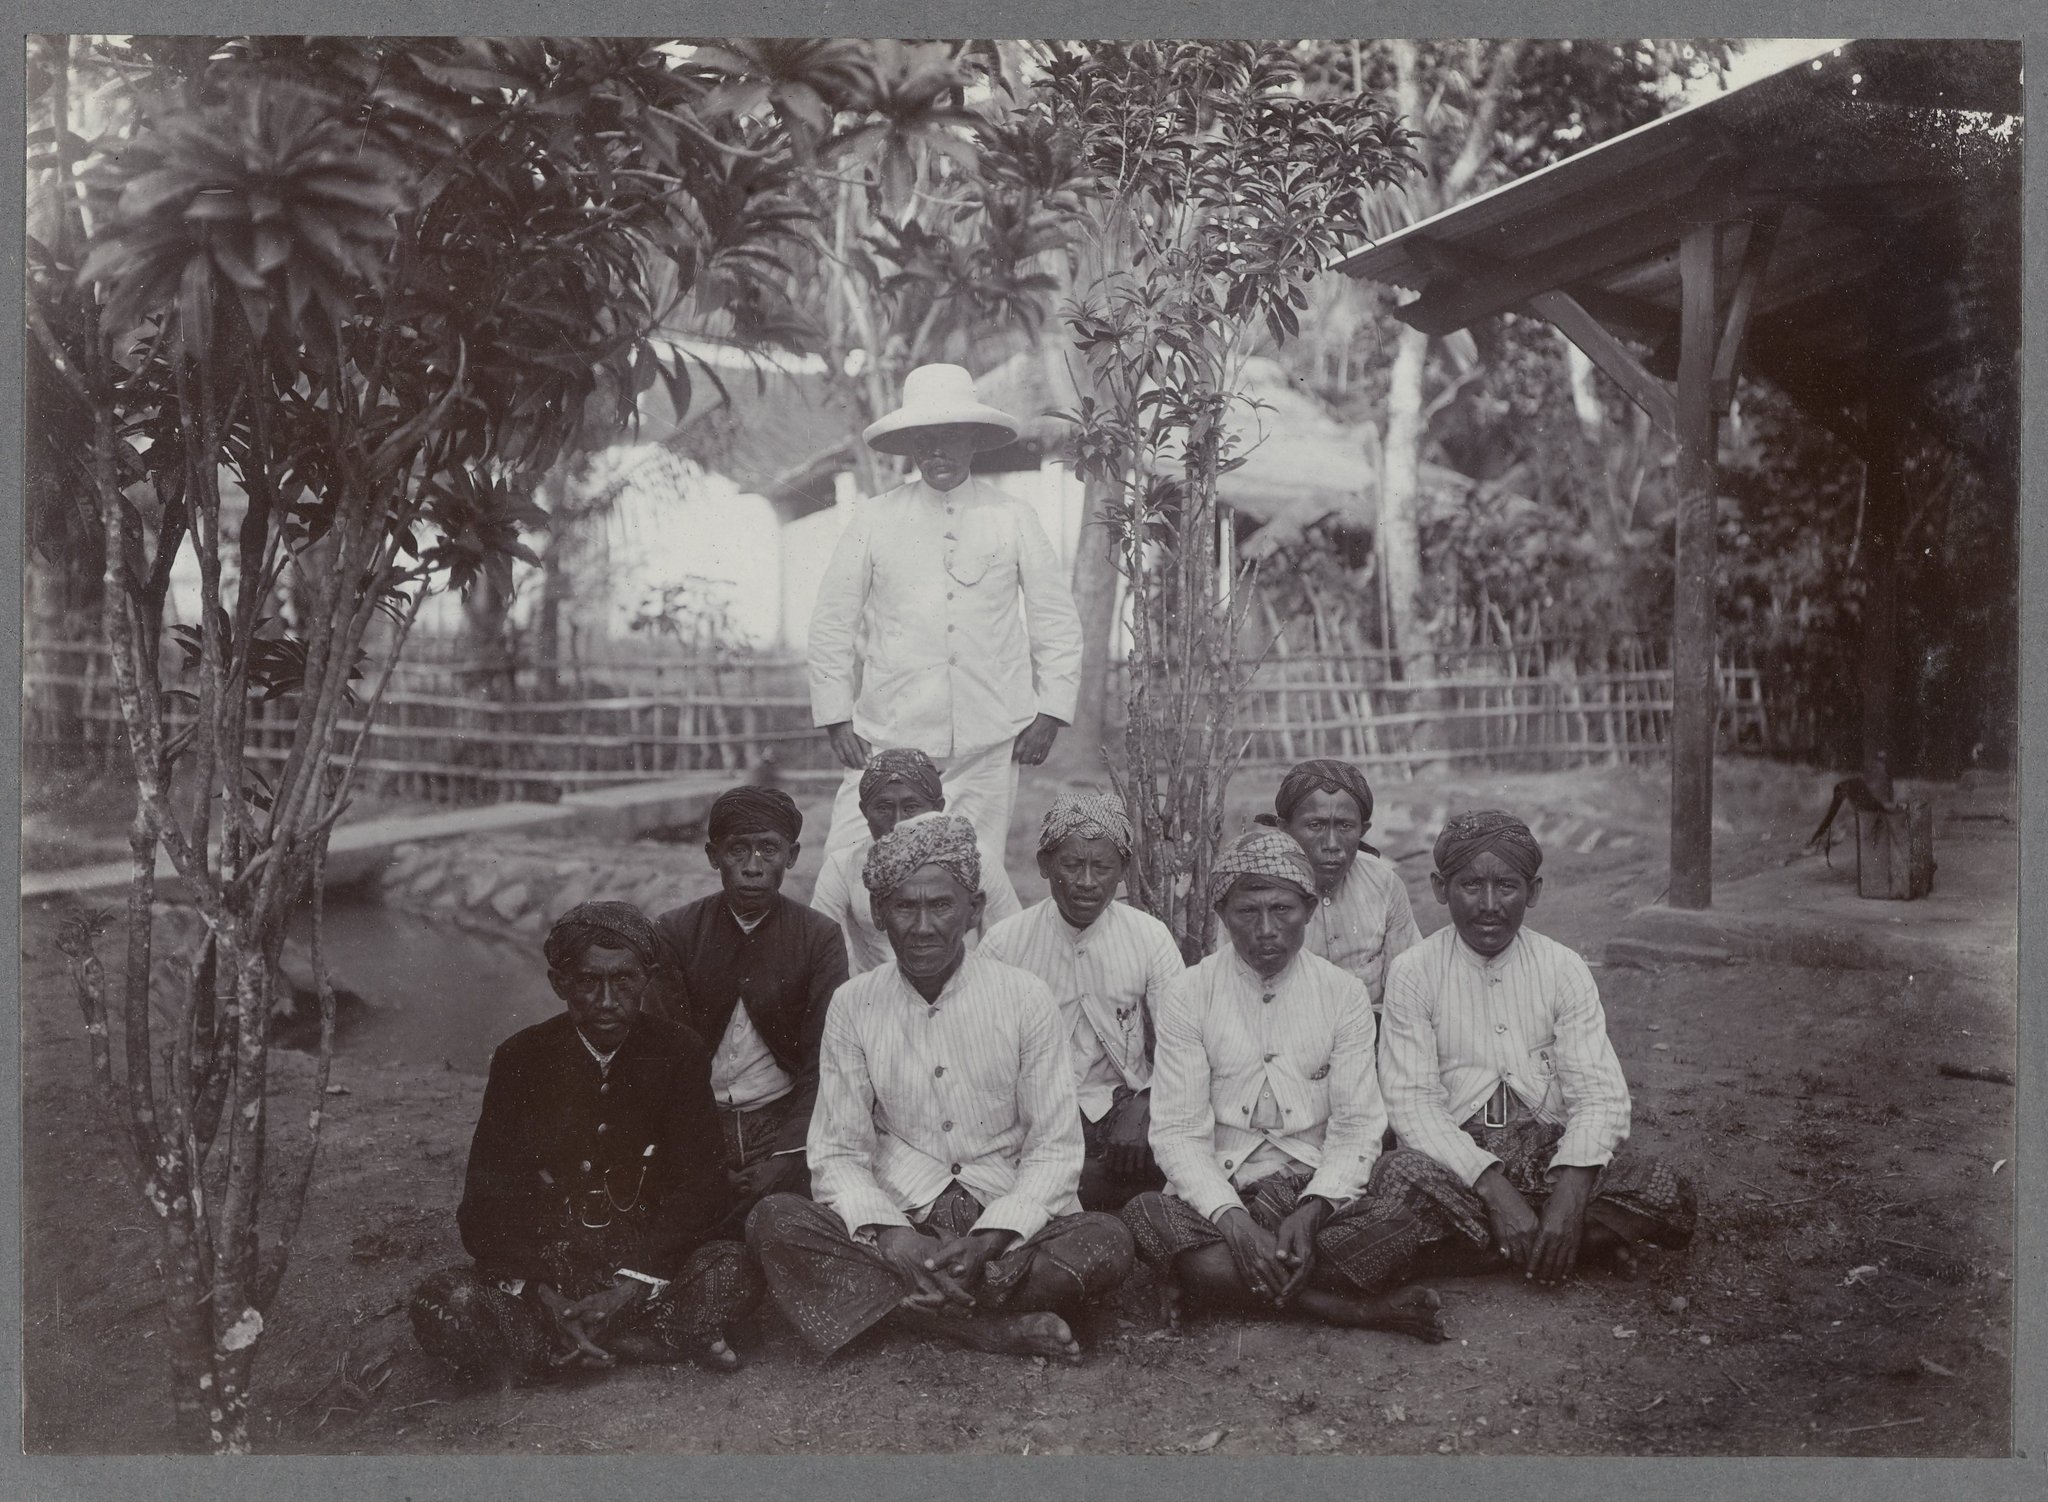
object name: photograph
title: Opzichter met werknemers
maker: Anonymous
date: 1900-1919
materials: photographic support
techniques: collodion silver print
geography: comal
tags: colonial system, plantation, director, boss (in modern industry), (non-fruit) products of plants or trees: sugarcane, industrial structures (+ men (labourers))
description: Een Europese opzichter staande bij een groep op de grond zittende Javaanse werknemers. Rechts een afdak. Onderdeel van het fotoalbum van de Tjomal suikerfabriek in de periode ca. 1900-1919.